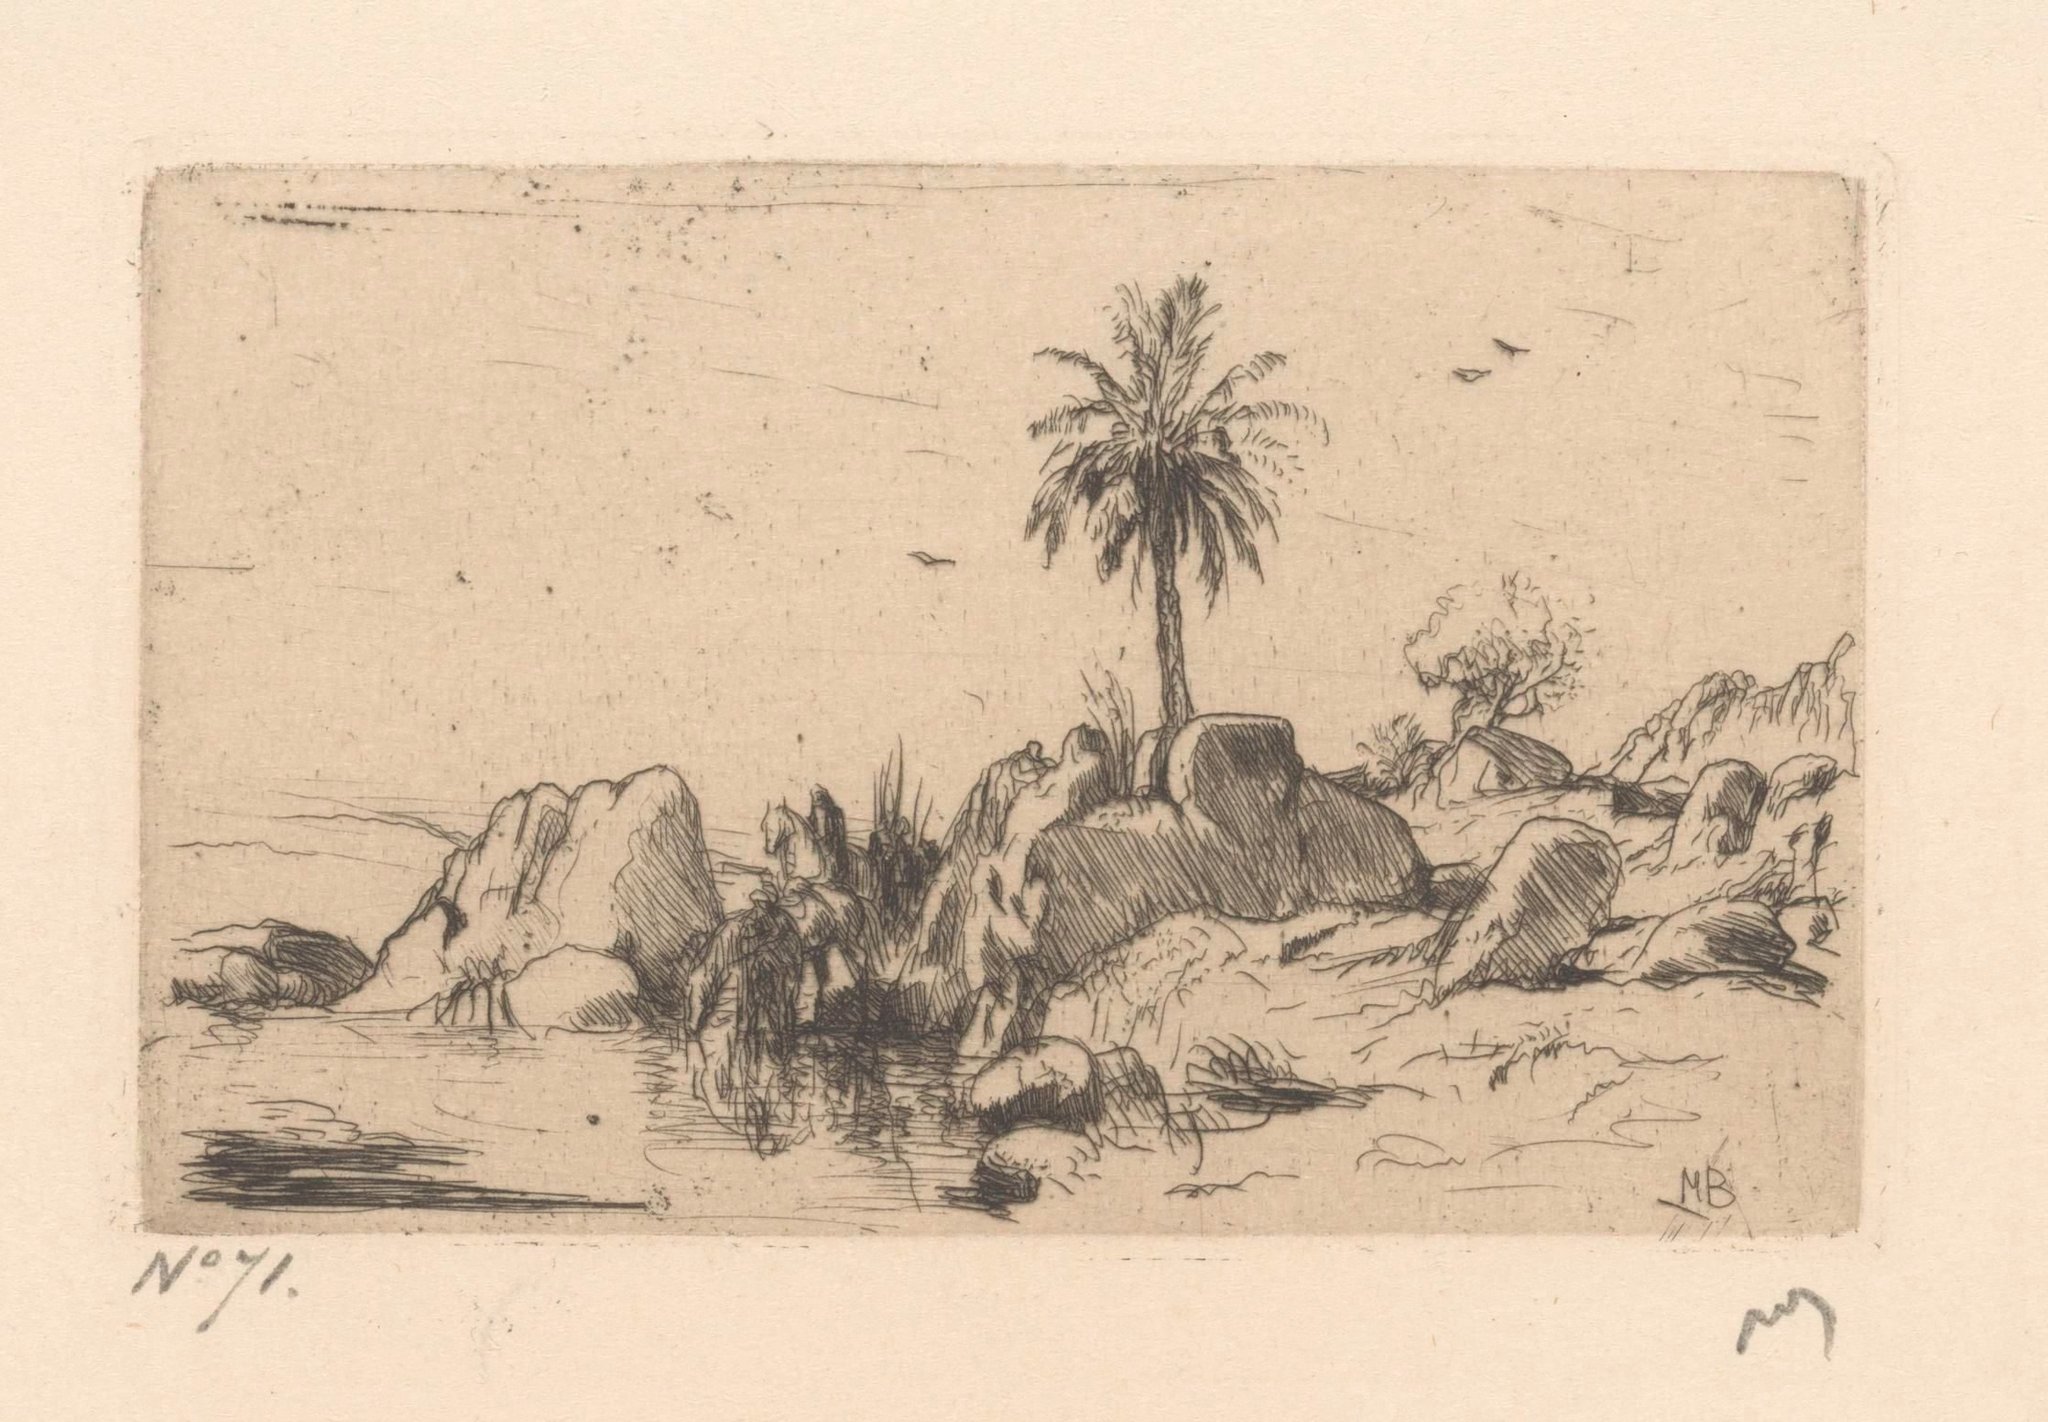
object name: print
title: Oase met palm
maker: marius bauer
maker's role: draughtsman, print maker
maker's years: 1867-1932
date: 1902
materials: paper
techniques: etching, intaglio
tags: oasis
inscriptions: collector's mark: Lugt 2228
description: Een palm aan het water in een rotsachtig landschap. Op de achtergrond nadert een figuur op een paard.